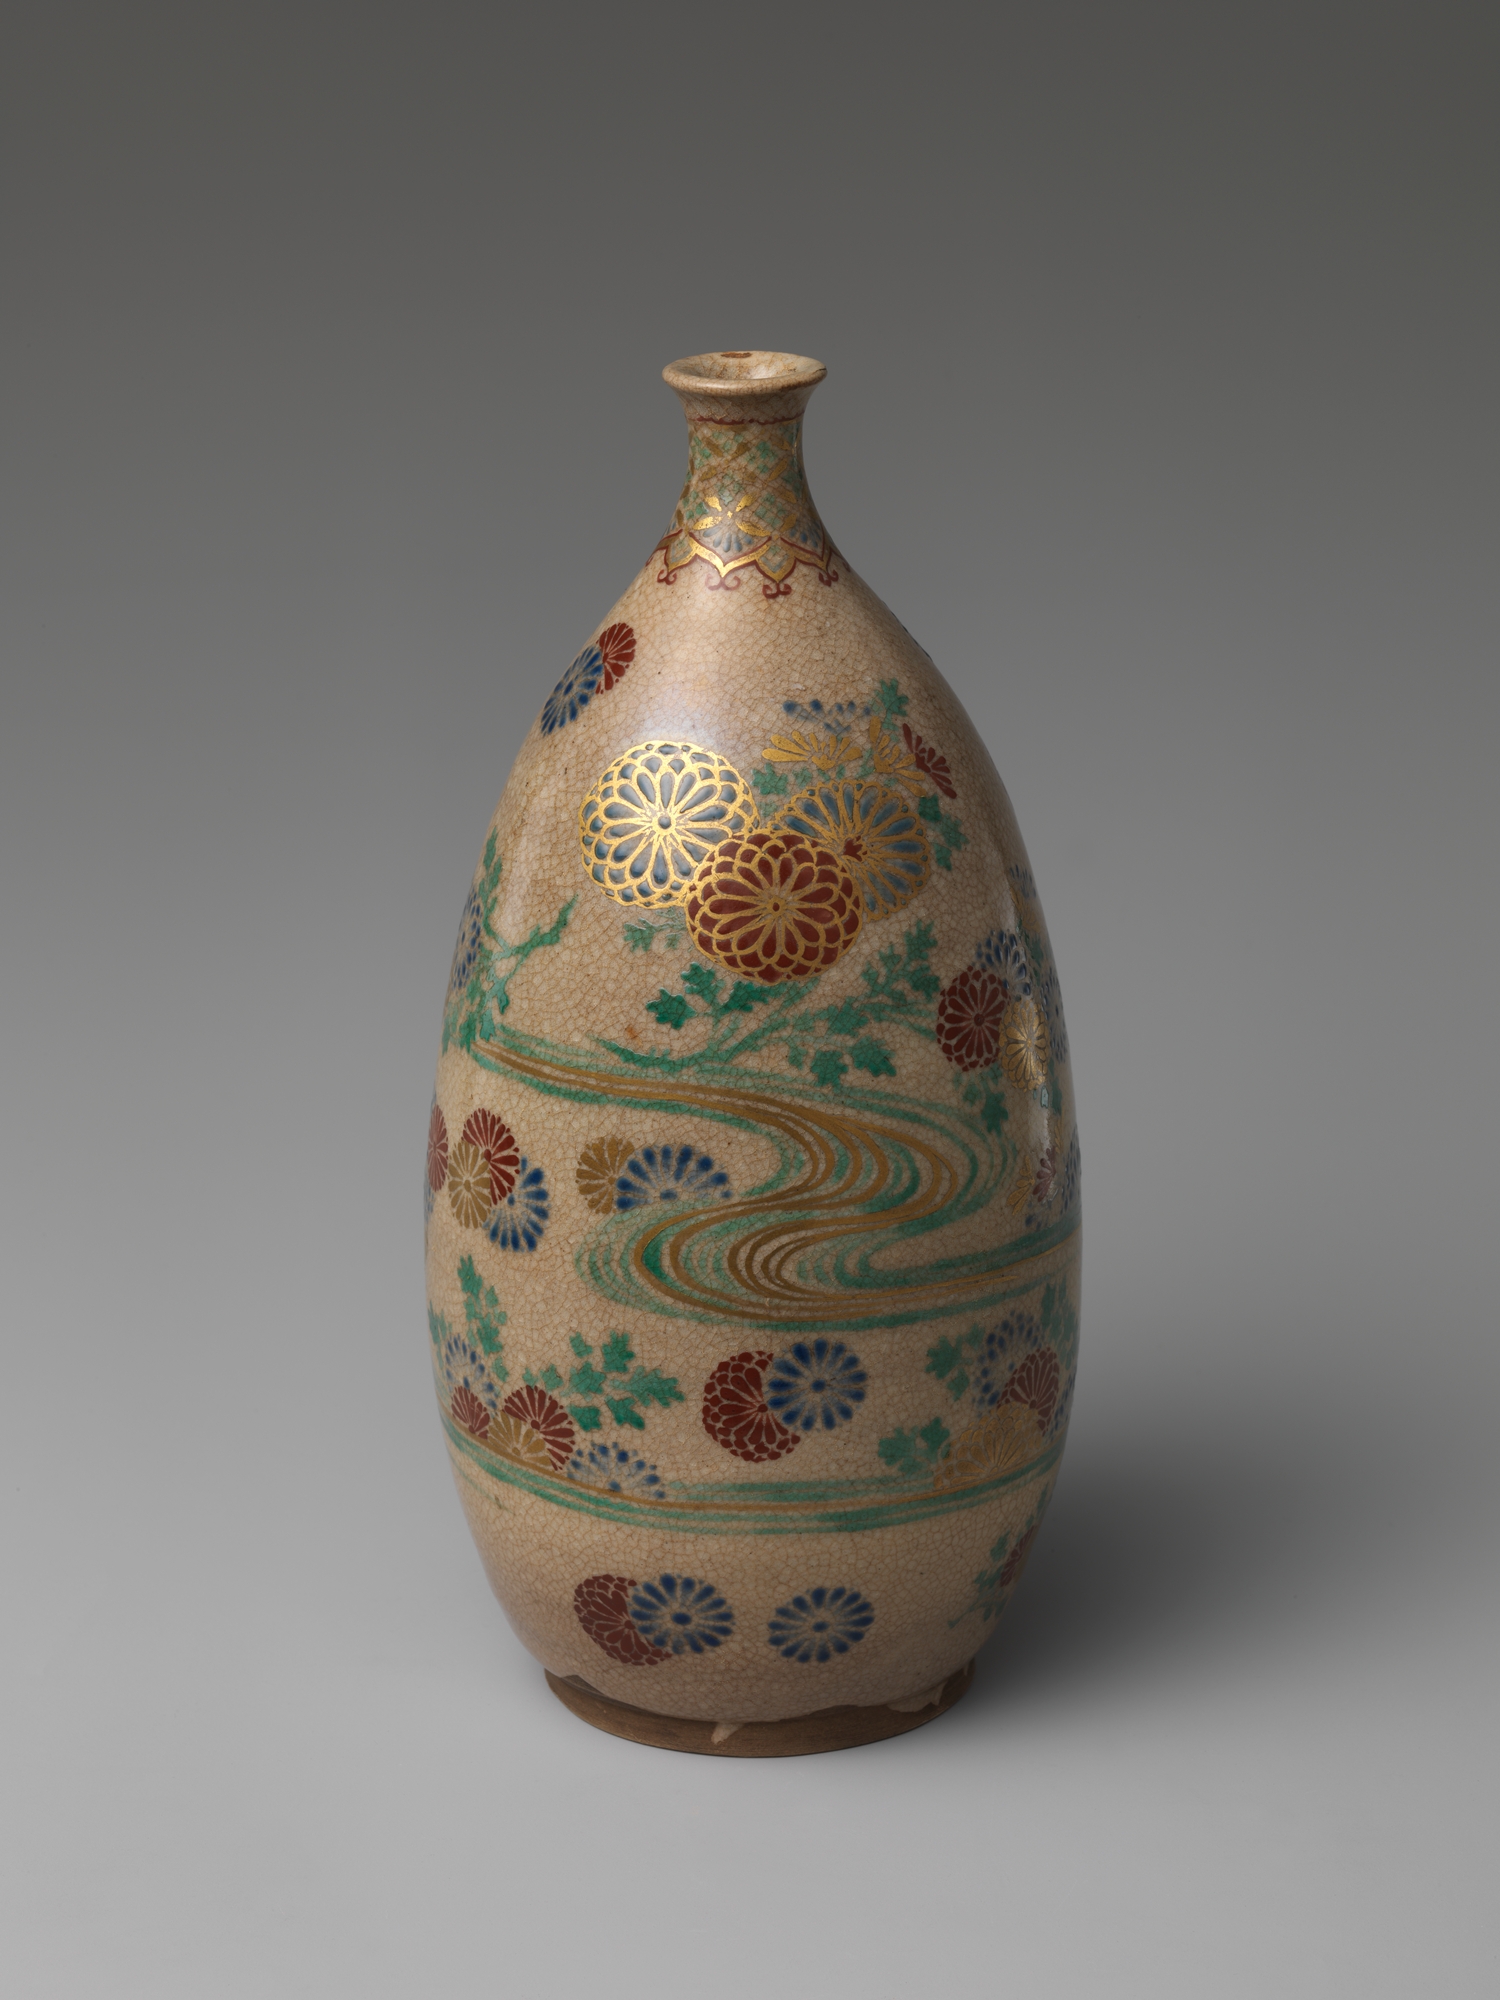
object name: sake bottle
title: Ninsei-style Sake Bottle with Floral Patterning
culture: japanese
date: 1734-1766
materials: clay, enamel, glaze, gold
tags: flowers